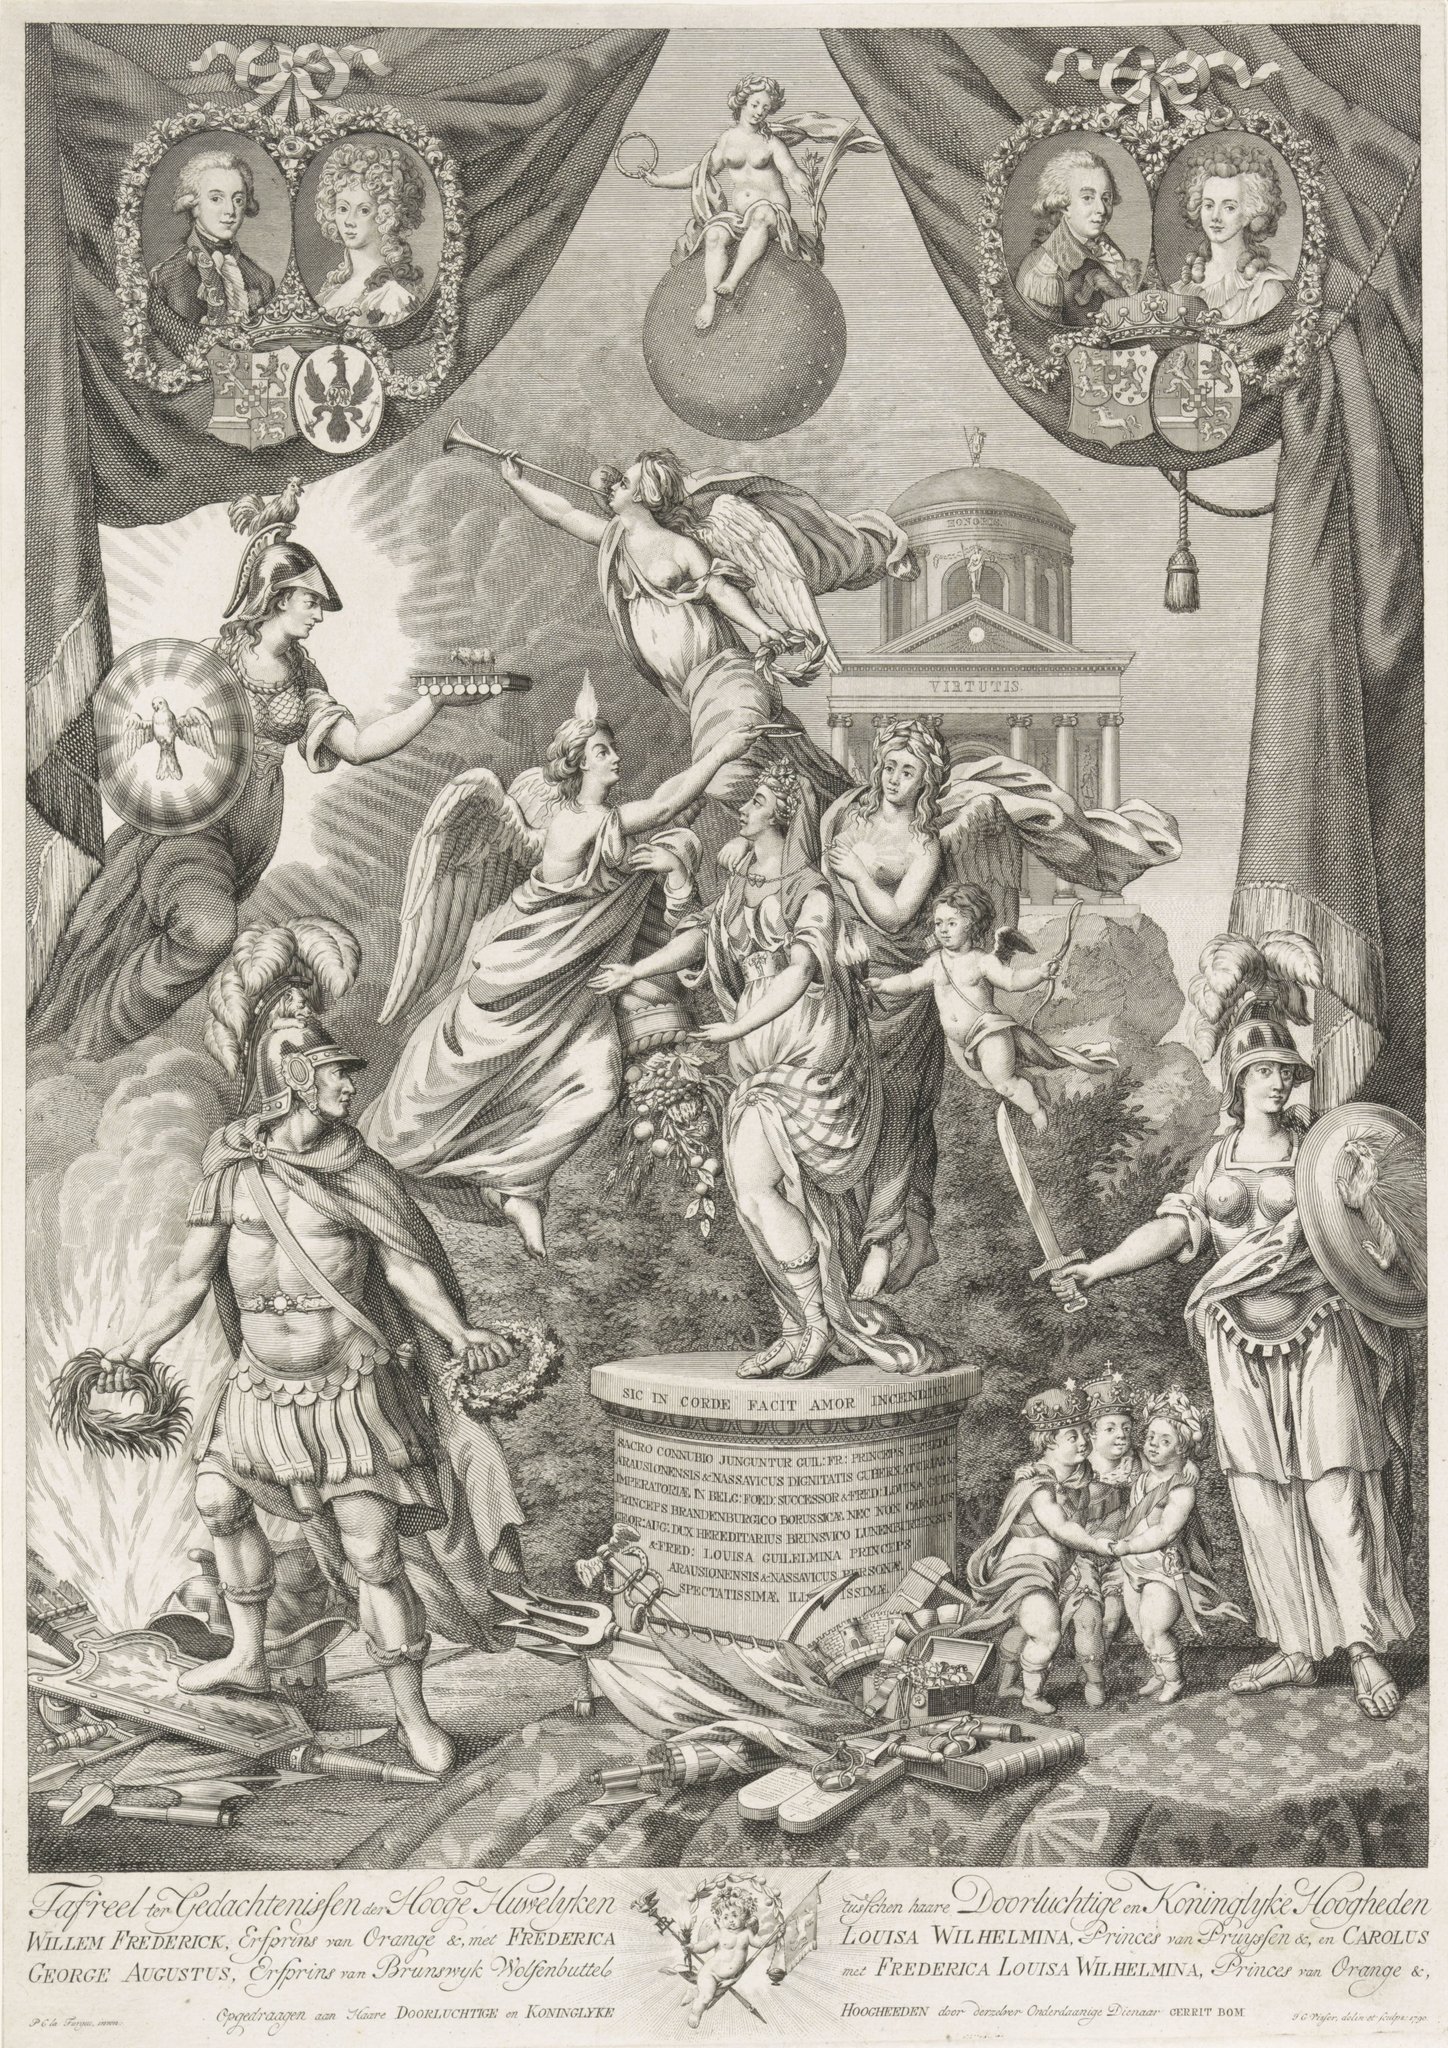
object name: print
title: Tafreel ter Gedachtenissen der Hooge Huwelyken tusschen (...) Willem Frederick, Erfprins van Orange &, met Frederica Louisa Wilhelmina, Princes van Pruyssen &, en Carolus George Augustus, Erfprins van Brunswyk Wolfenbuttel met Frederica Louisa Wilhelmina, Princes van Orange (...)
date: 1790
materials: paper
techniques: engraving, etching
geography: northern netherlands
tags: the hague, berlin, william i of the netherlands, karel van brunswijk-wolfenbüttel, amsterdam, louise (prinses van oranje-nassau), wilhelmina frederica louisa (koningin der nederlanden), marriage, married couple, 'matrimonium'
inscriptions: collector's mark: Lugt 2166, collector's mark: Lugt 963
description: Allegorische voorstelling ter ere van het huwelijk van prinses Louise van Oranje-Nassau met Karel van Brunswijk-Wolfenbüttel te Den Haag op 14 oktober 1790 en van prins Willem Frederik (de latere koning Willem I) met Wilhelmina Frederica van Pruisen op 1 oktober 1791. Bovenaan de twee bruidsparen. Huwelijk op een voetstuk wordt gekroond door Godsdienst en terwijl de Deugd haar een halsketting omdoet. Links Mars die wapens verbrandt, rechts de personificatie van de huwelijksplechtigheden, met een wapenschild met een stekelvarken.